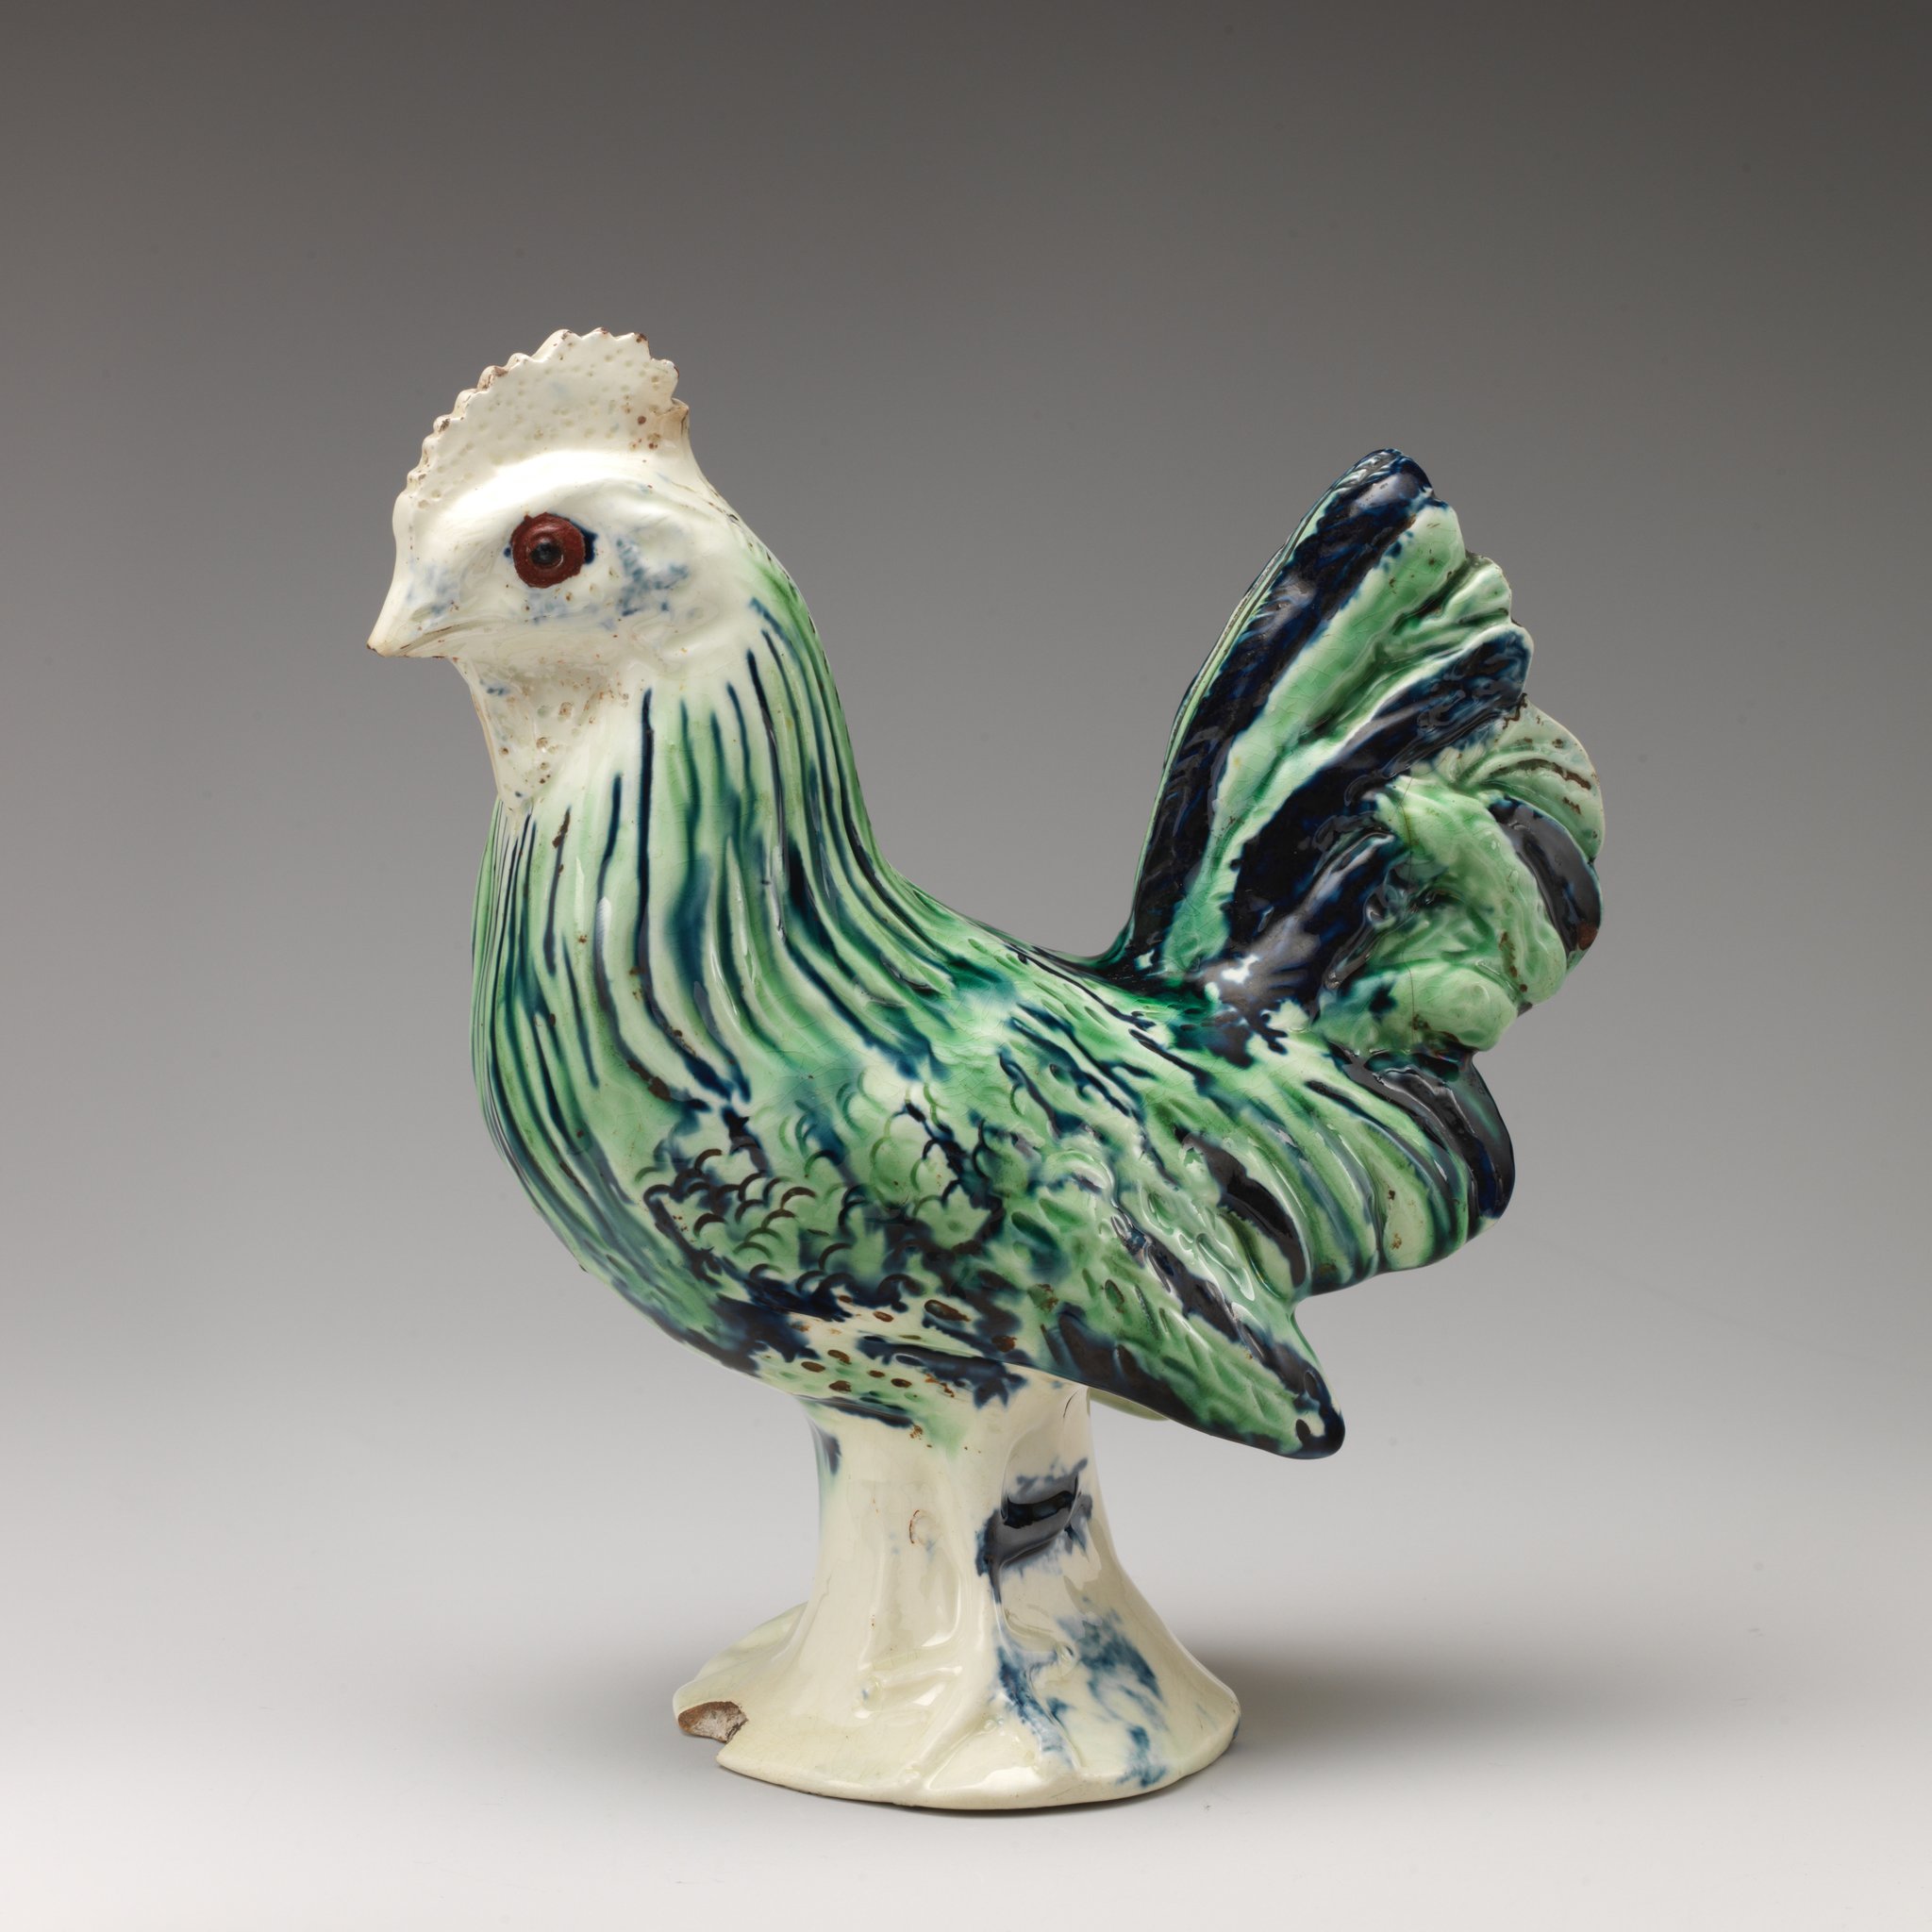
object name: figure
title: Cock (one of a pair)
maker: whieldon type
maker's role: maker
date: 1750-1760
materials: earthenware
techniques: glazing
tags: roosters